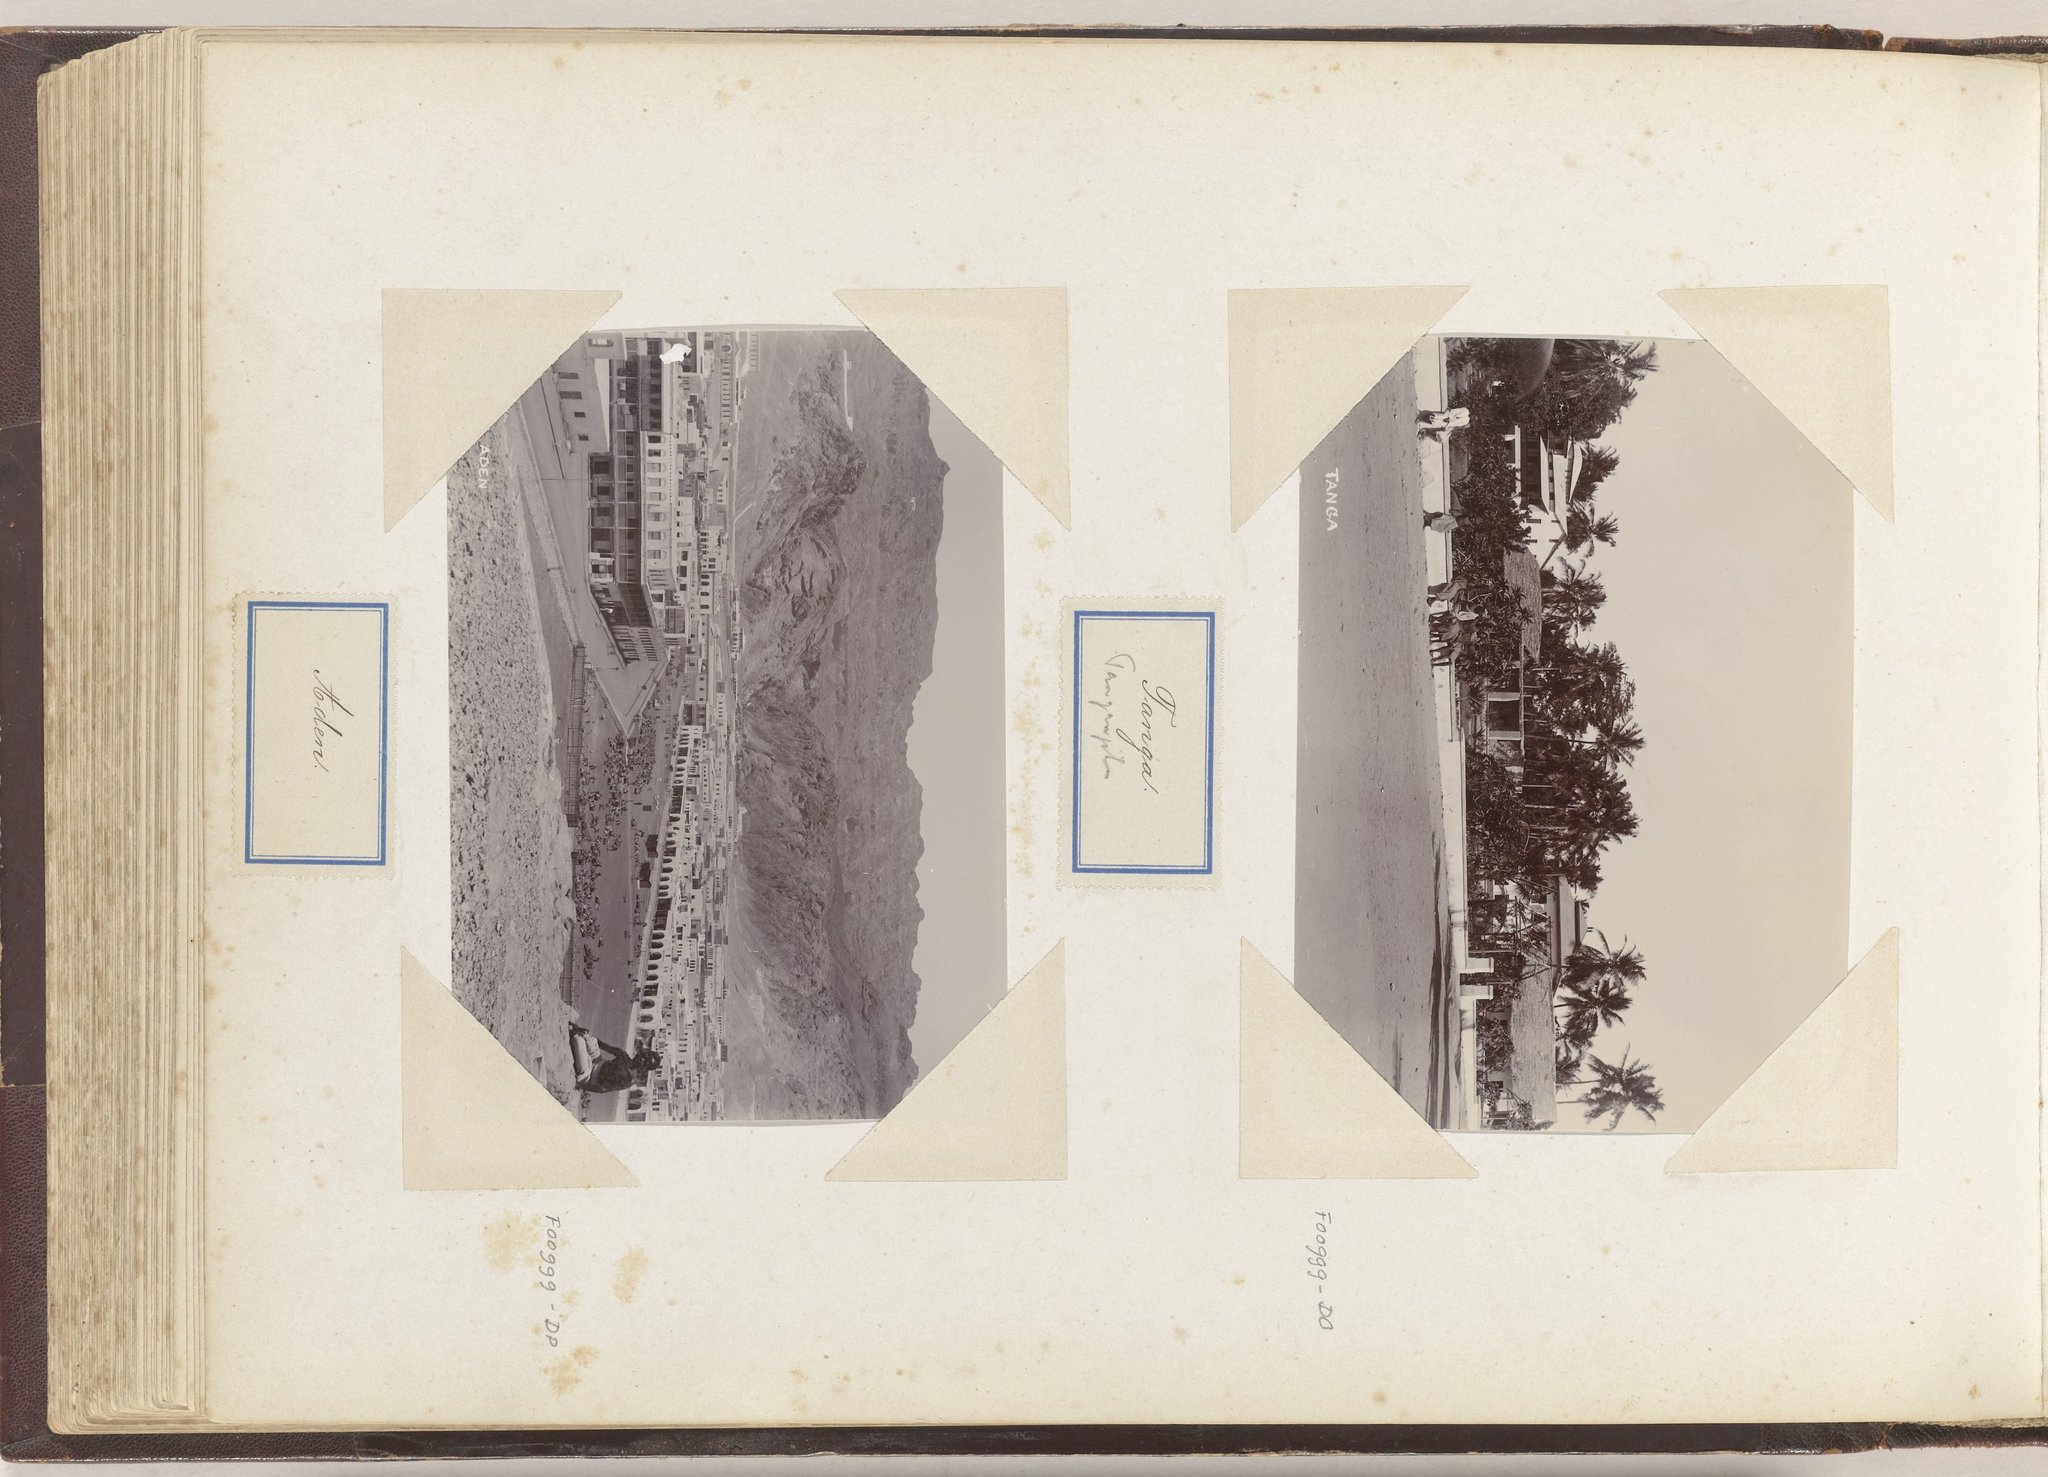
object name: photograph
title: Gezicht op Aden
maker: Anonymous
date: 1900-1920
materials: paper, photographic support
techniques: gelatin silver print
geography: aden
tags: city-view in general; 'veduta'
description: Onderdeel van Album met 191 foto's van een reis naar en door Zuid-Afrika.